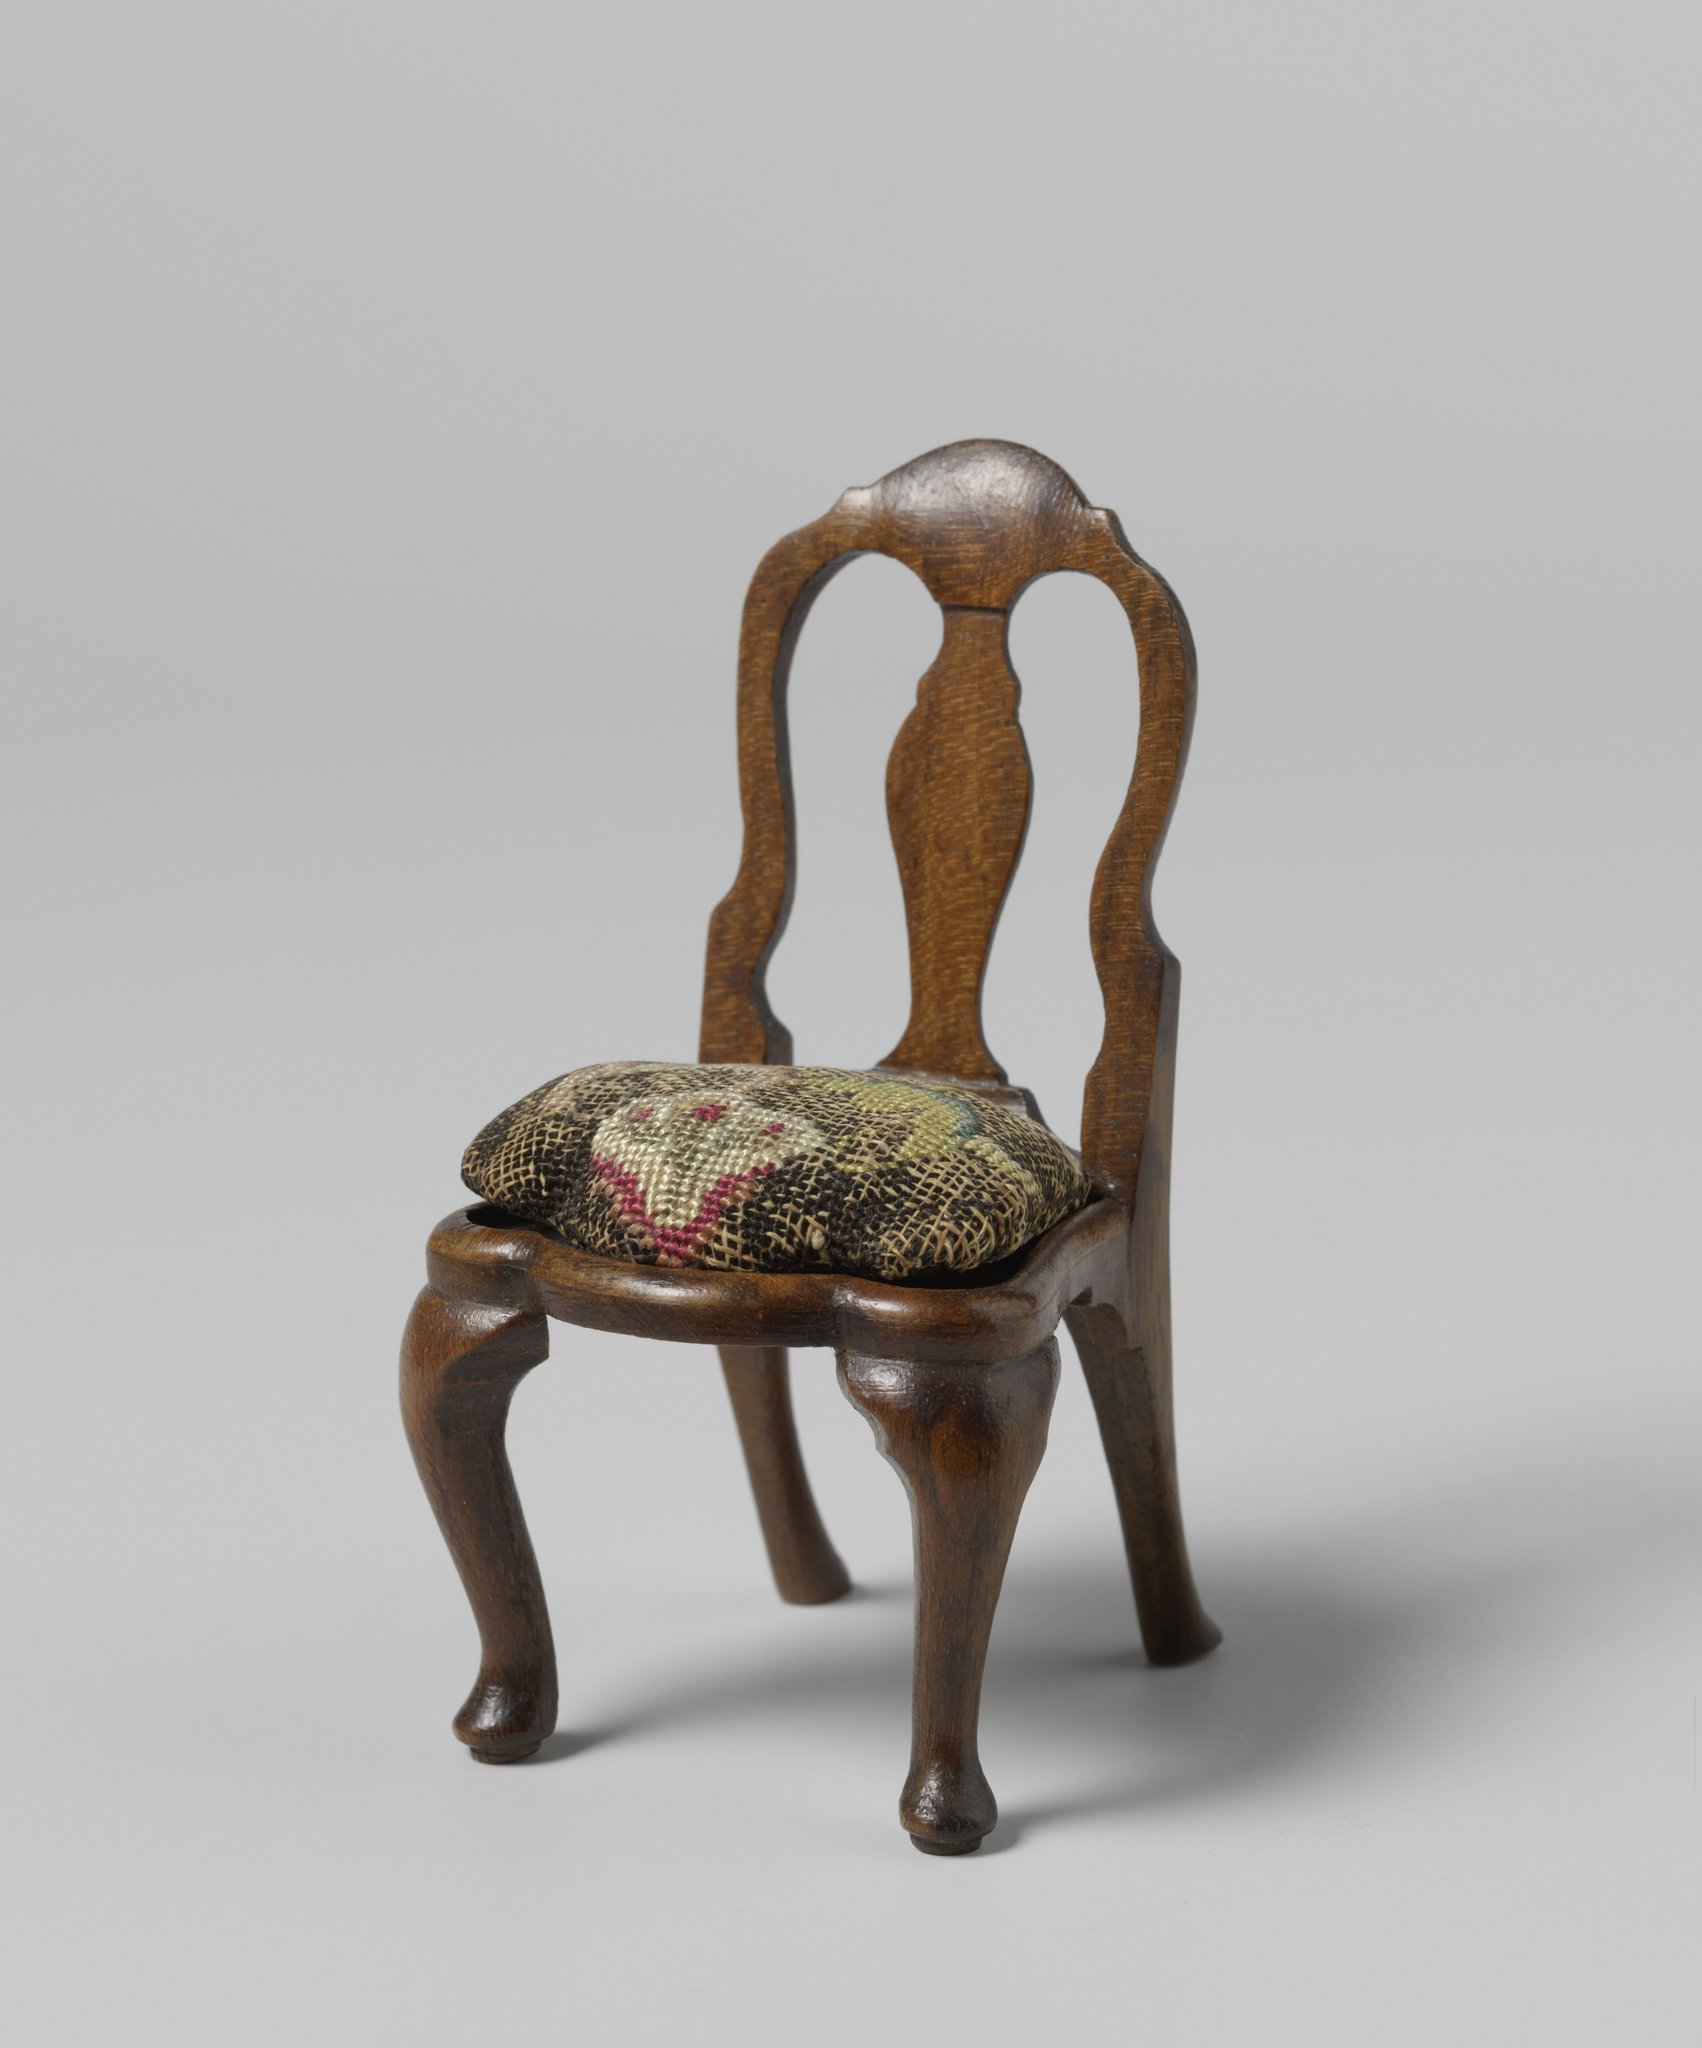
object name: miniature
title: Stoel, behorend tot een elfdelig ameublement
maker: Anonymous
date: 1750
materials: silk, wood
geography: amsterdam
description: Stoel, vervaardigd van notenhout, behorend tot een elfdelig ameublement, bestaande uit een bank en tien stoelen. De zitting van buurduurwerk met blad- en bloemmotieven in zijde op linnen stramien, met een zachte vulling.